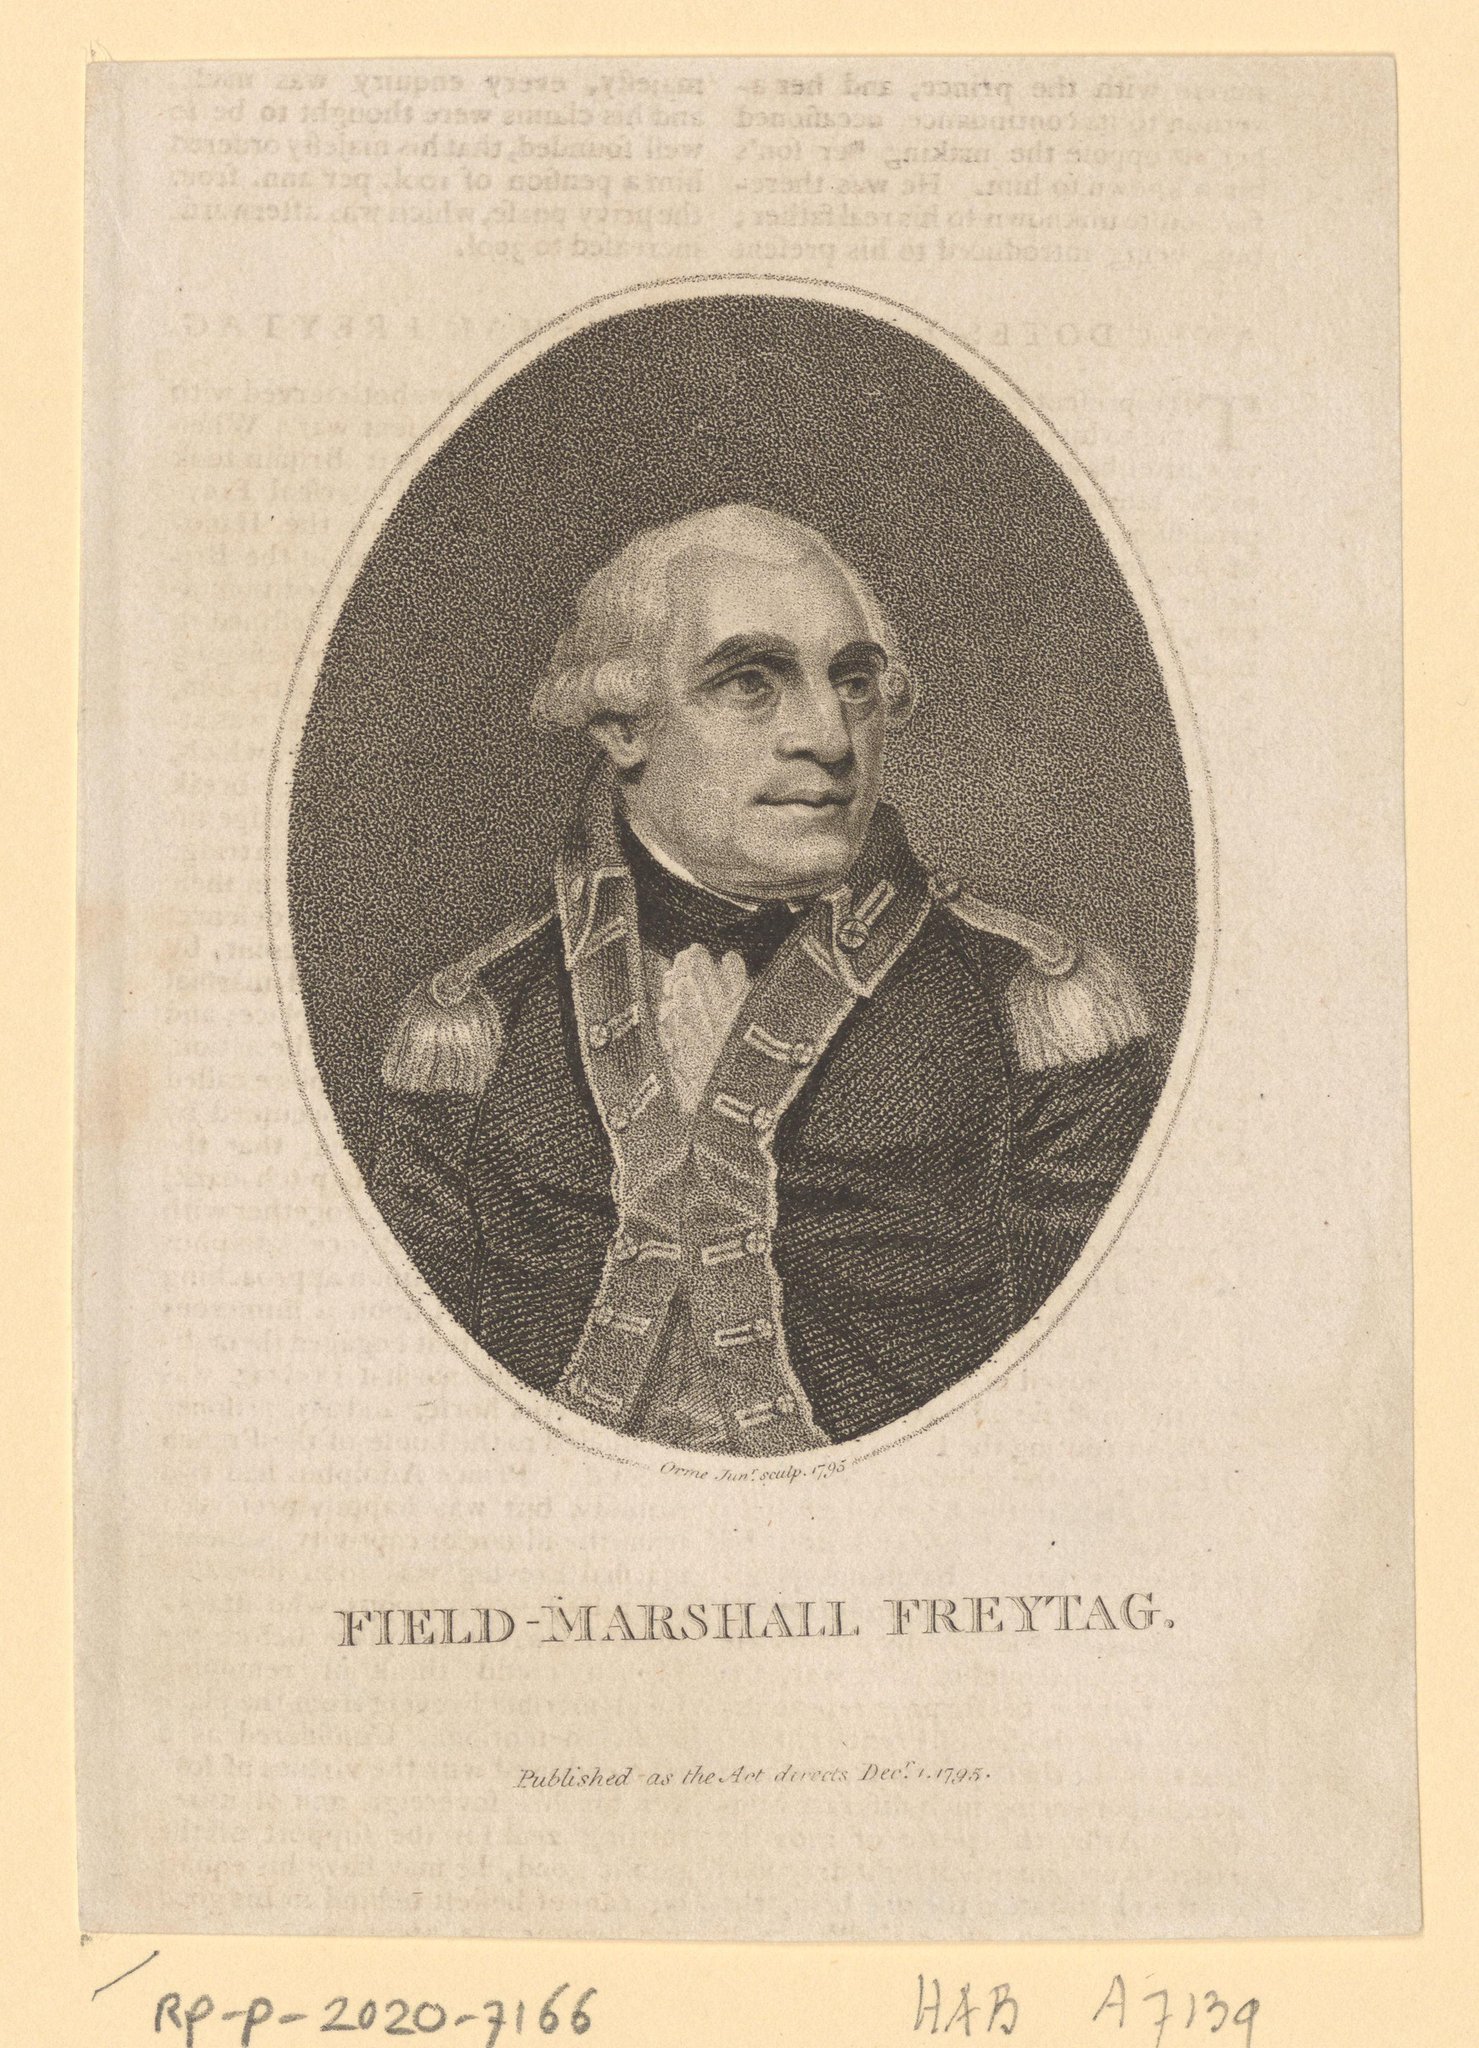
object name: print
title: Portret van Wilhelm von Freytag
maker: daniel orme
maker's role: print maker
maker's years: 1766-1802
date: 1712-1795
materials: paper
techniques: engraving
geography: england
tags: historical persons, officer, (military) uniforms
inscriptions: date